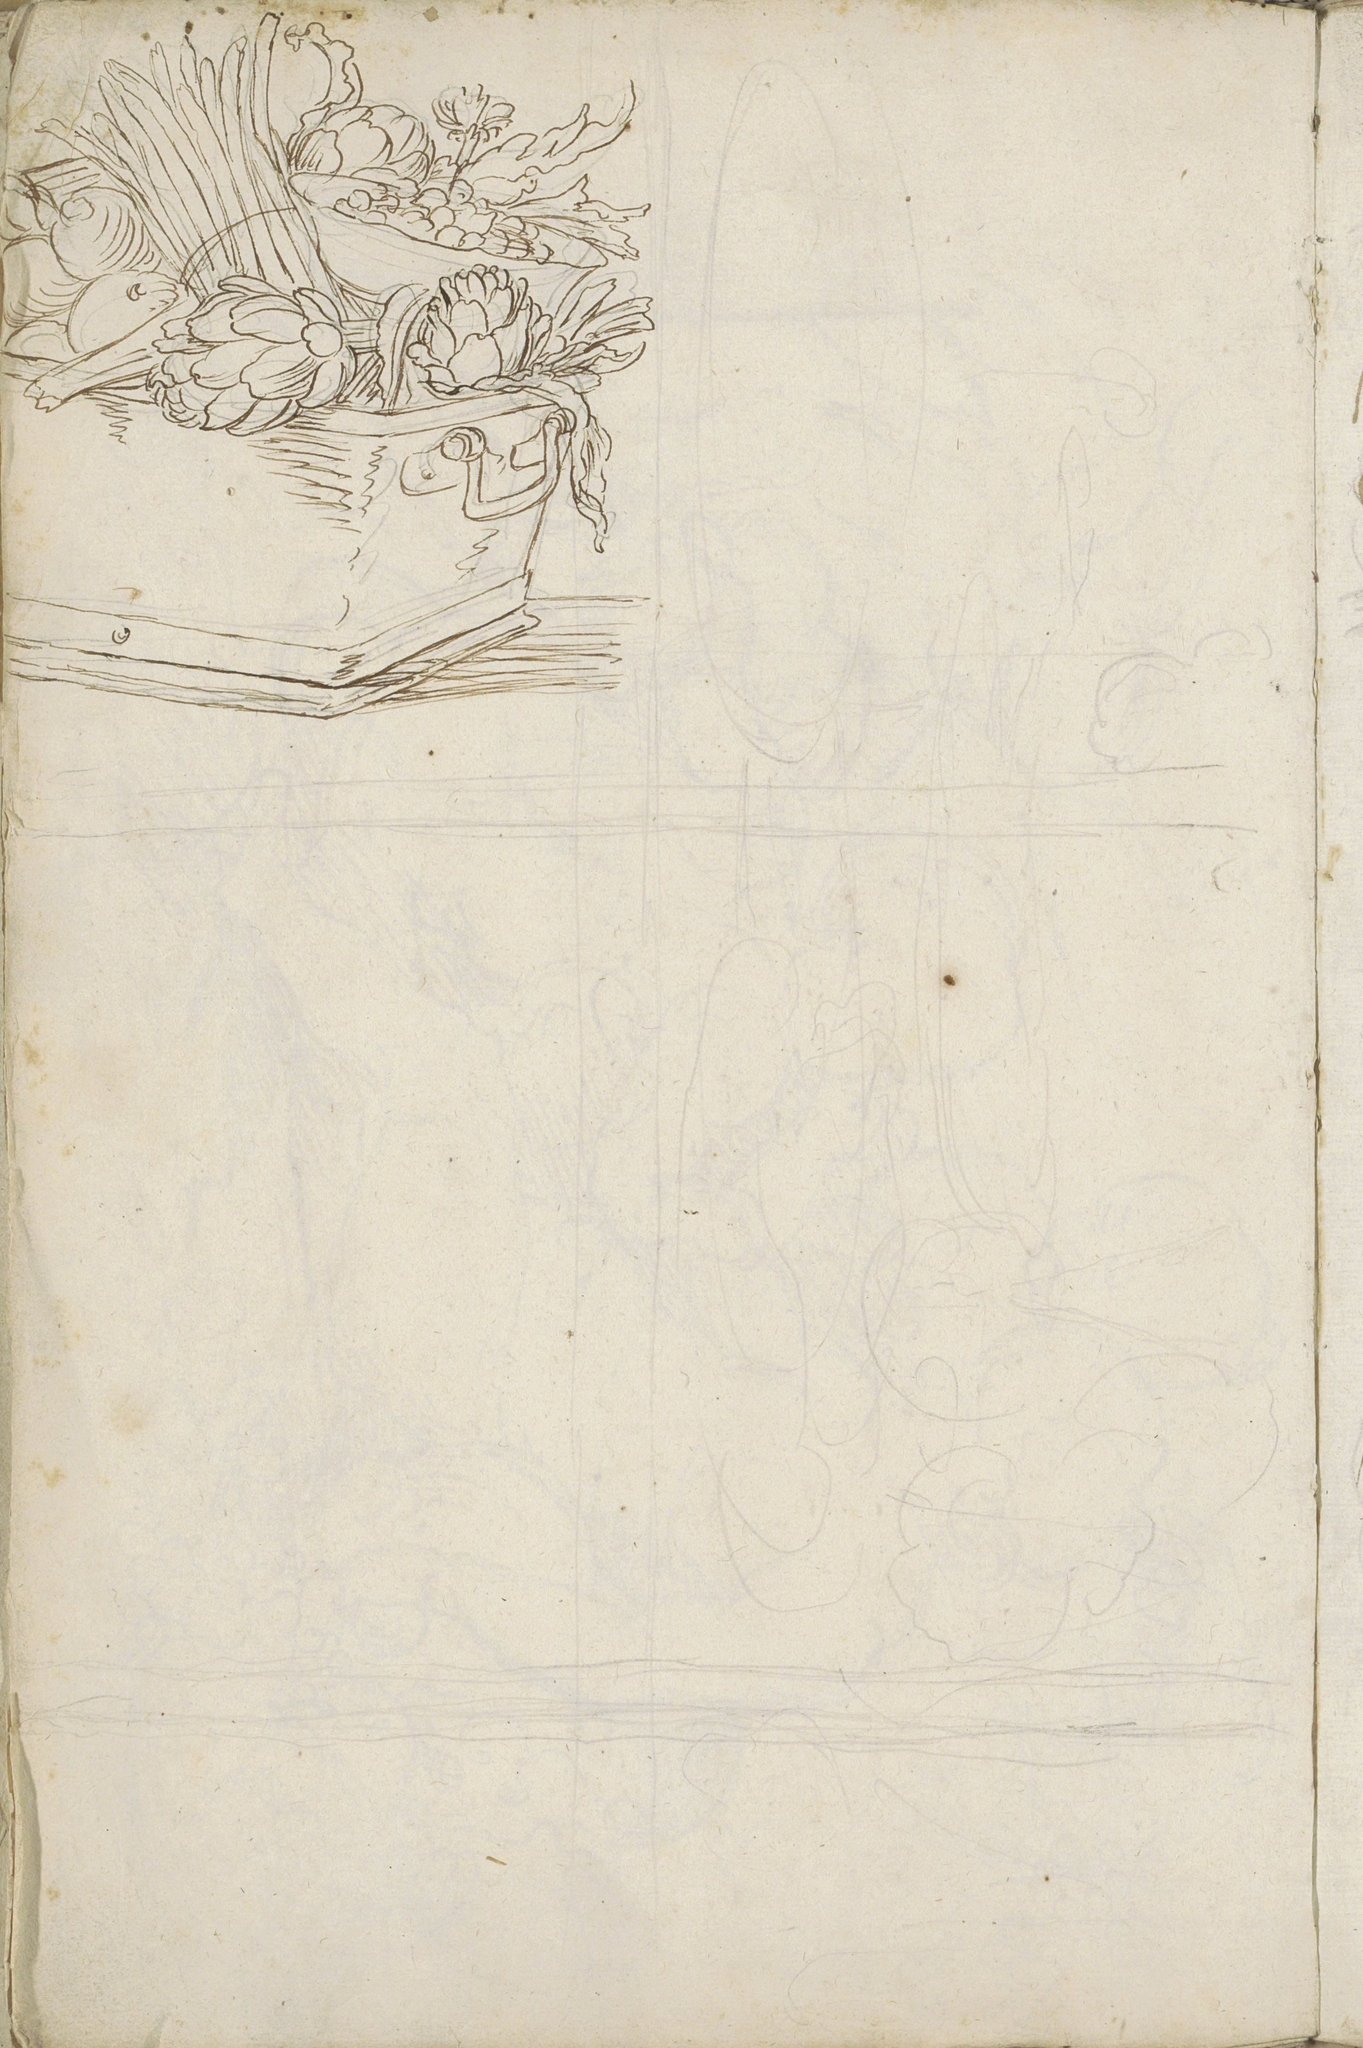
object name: sketchbook leaf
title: Groentemand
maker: paul de vos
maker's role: draughtsman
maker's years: 1595-1678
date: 1605-1678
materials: ink, paper, pencil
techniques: pen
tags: vegetables, container made of plant material other than wood: basket, dish, plate, saucer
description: Tekening in een vak van een raster. Tevens studies van schalen. Blad 12 verso uit een schetsboek met 15 bladen.